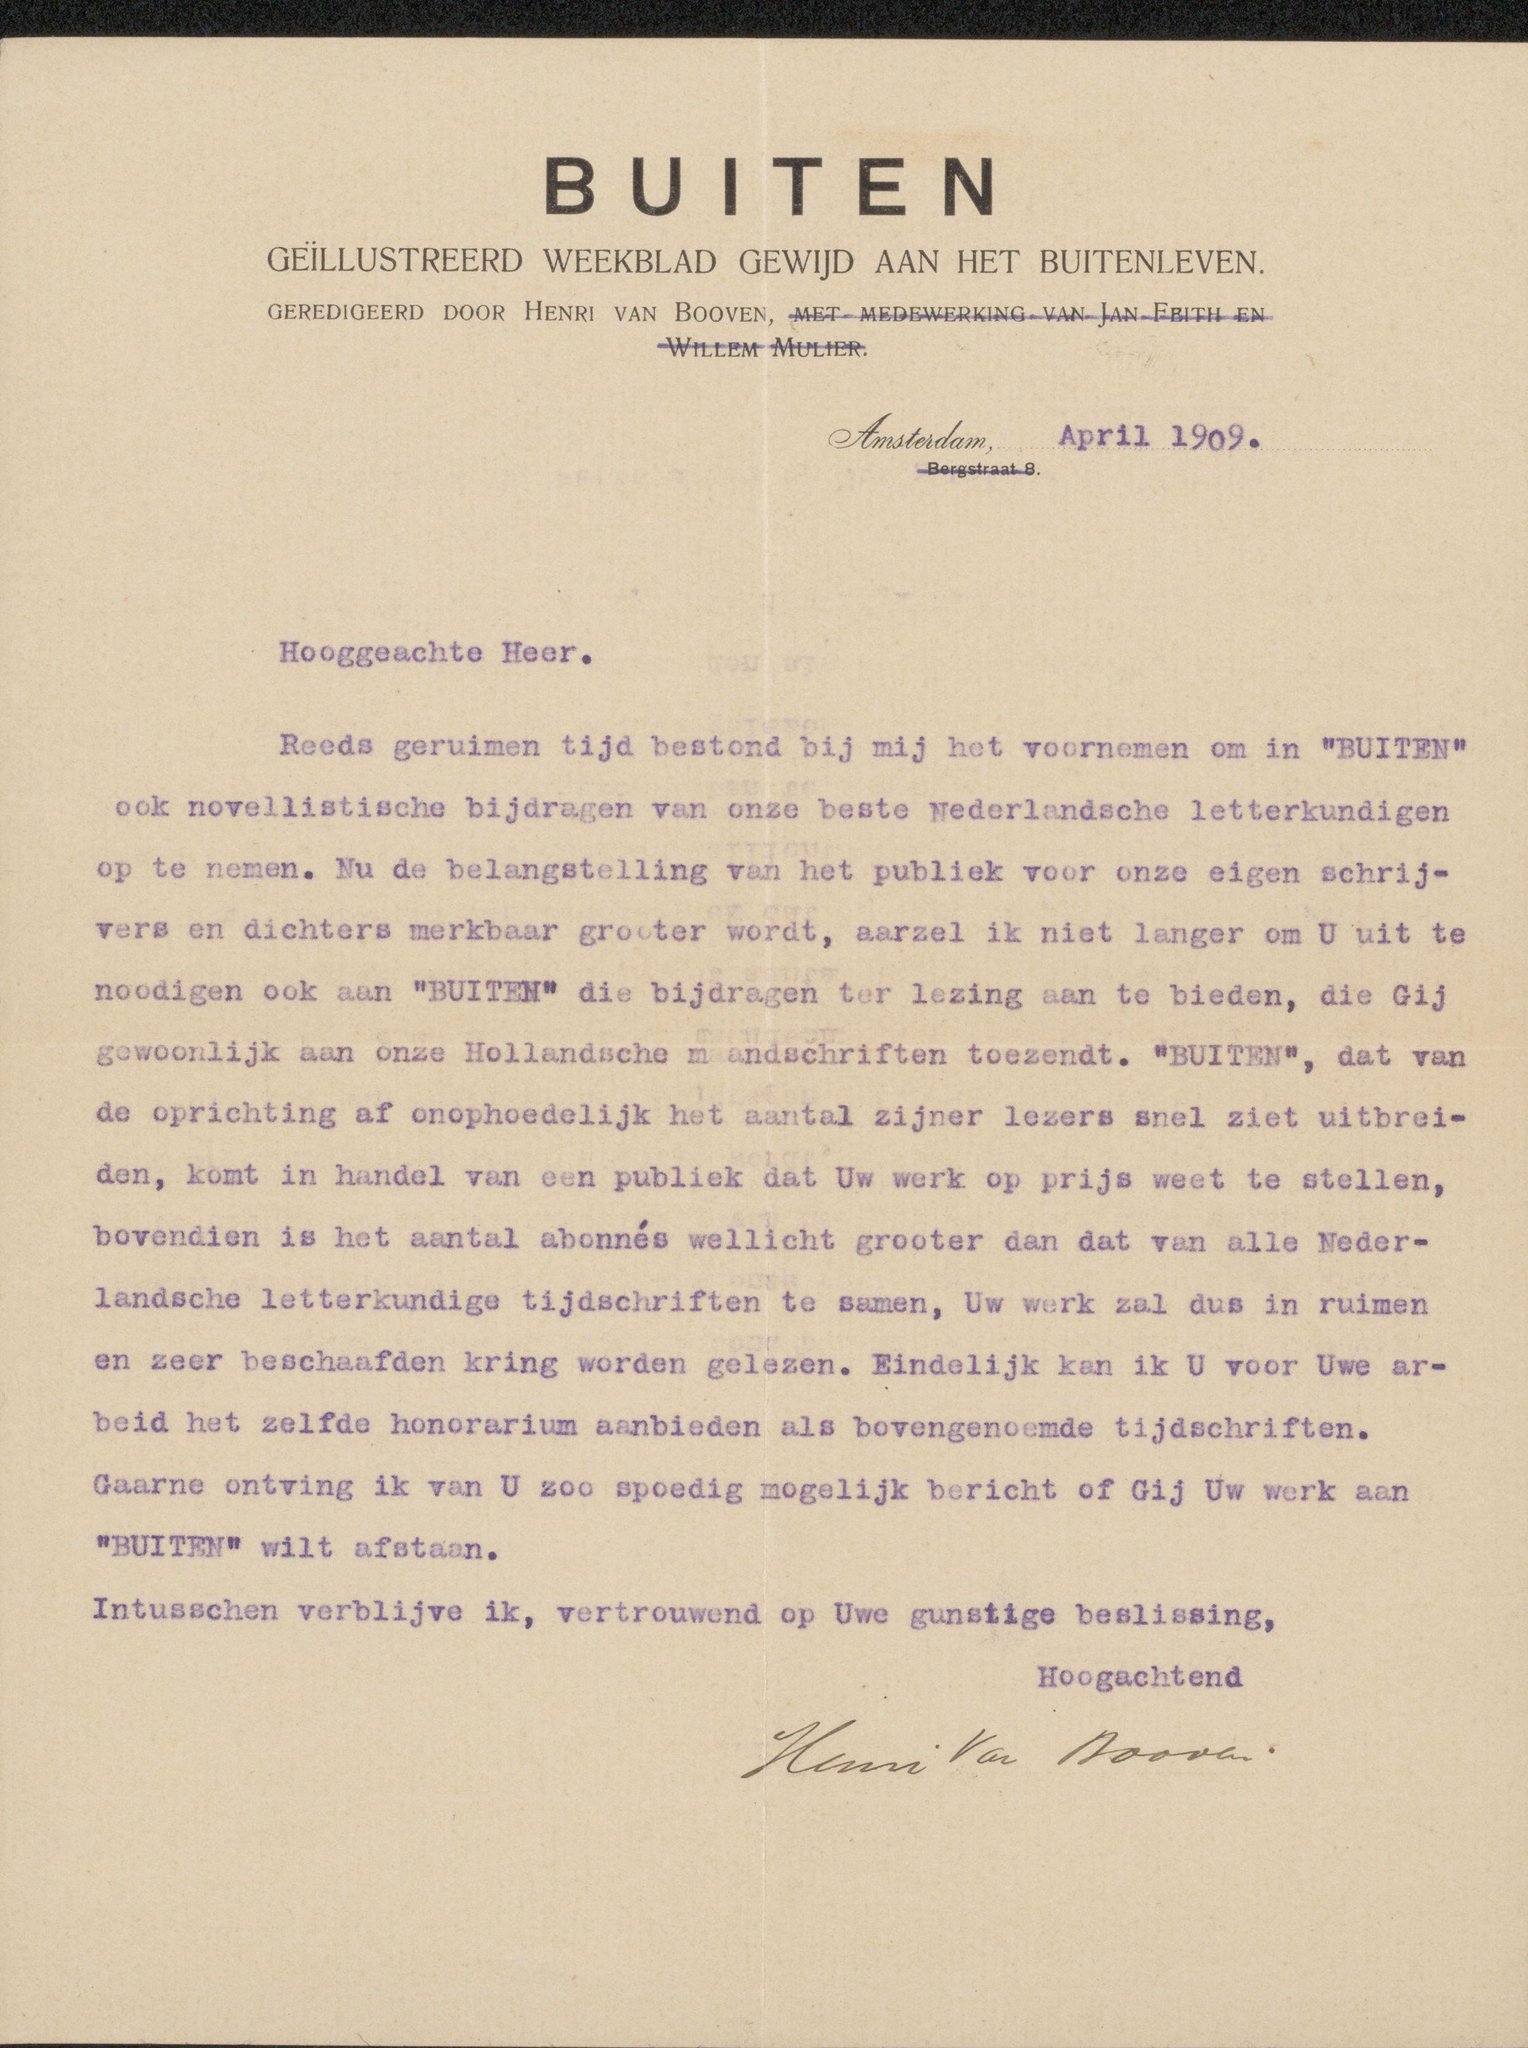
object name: letter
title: Brief aan Philip Zilcken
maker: henri van booven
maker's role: letterkundige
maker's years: 1877-1964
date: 1904-1909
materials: ink, paper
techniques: pen, printing, writing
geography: amsterdam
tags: the hague, painter, draughtsman, philip zilcken, literature ~ arts, money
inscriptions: collector's mark: ‘RPK’